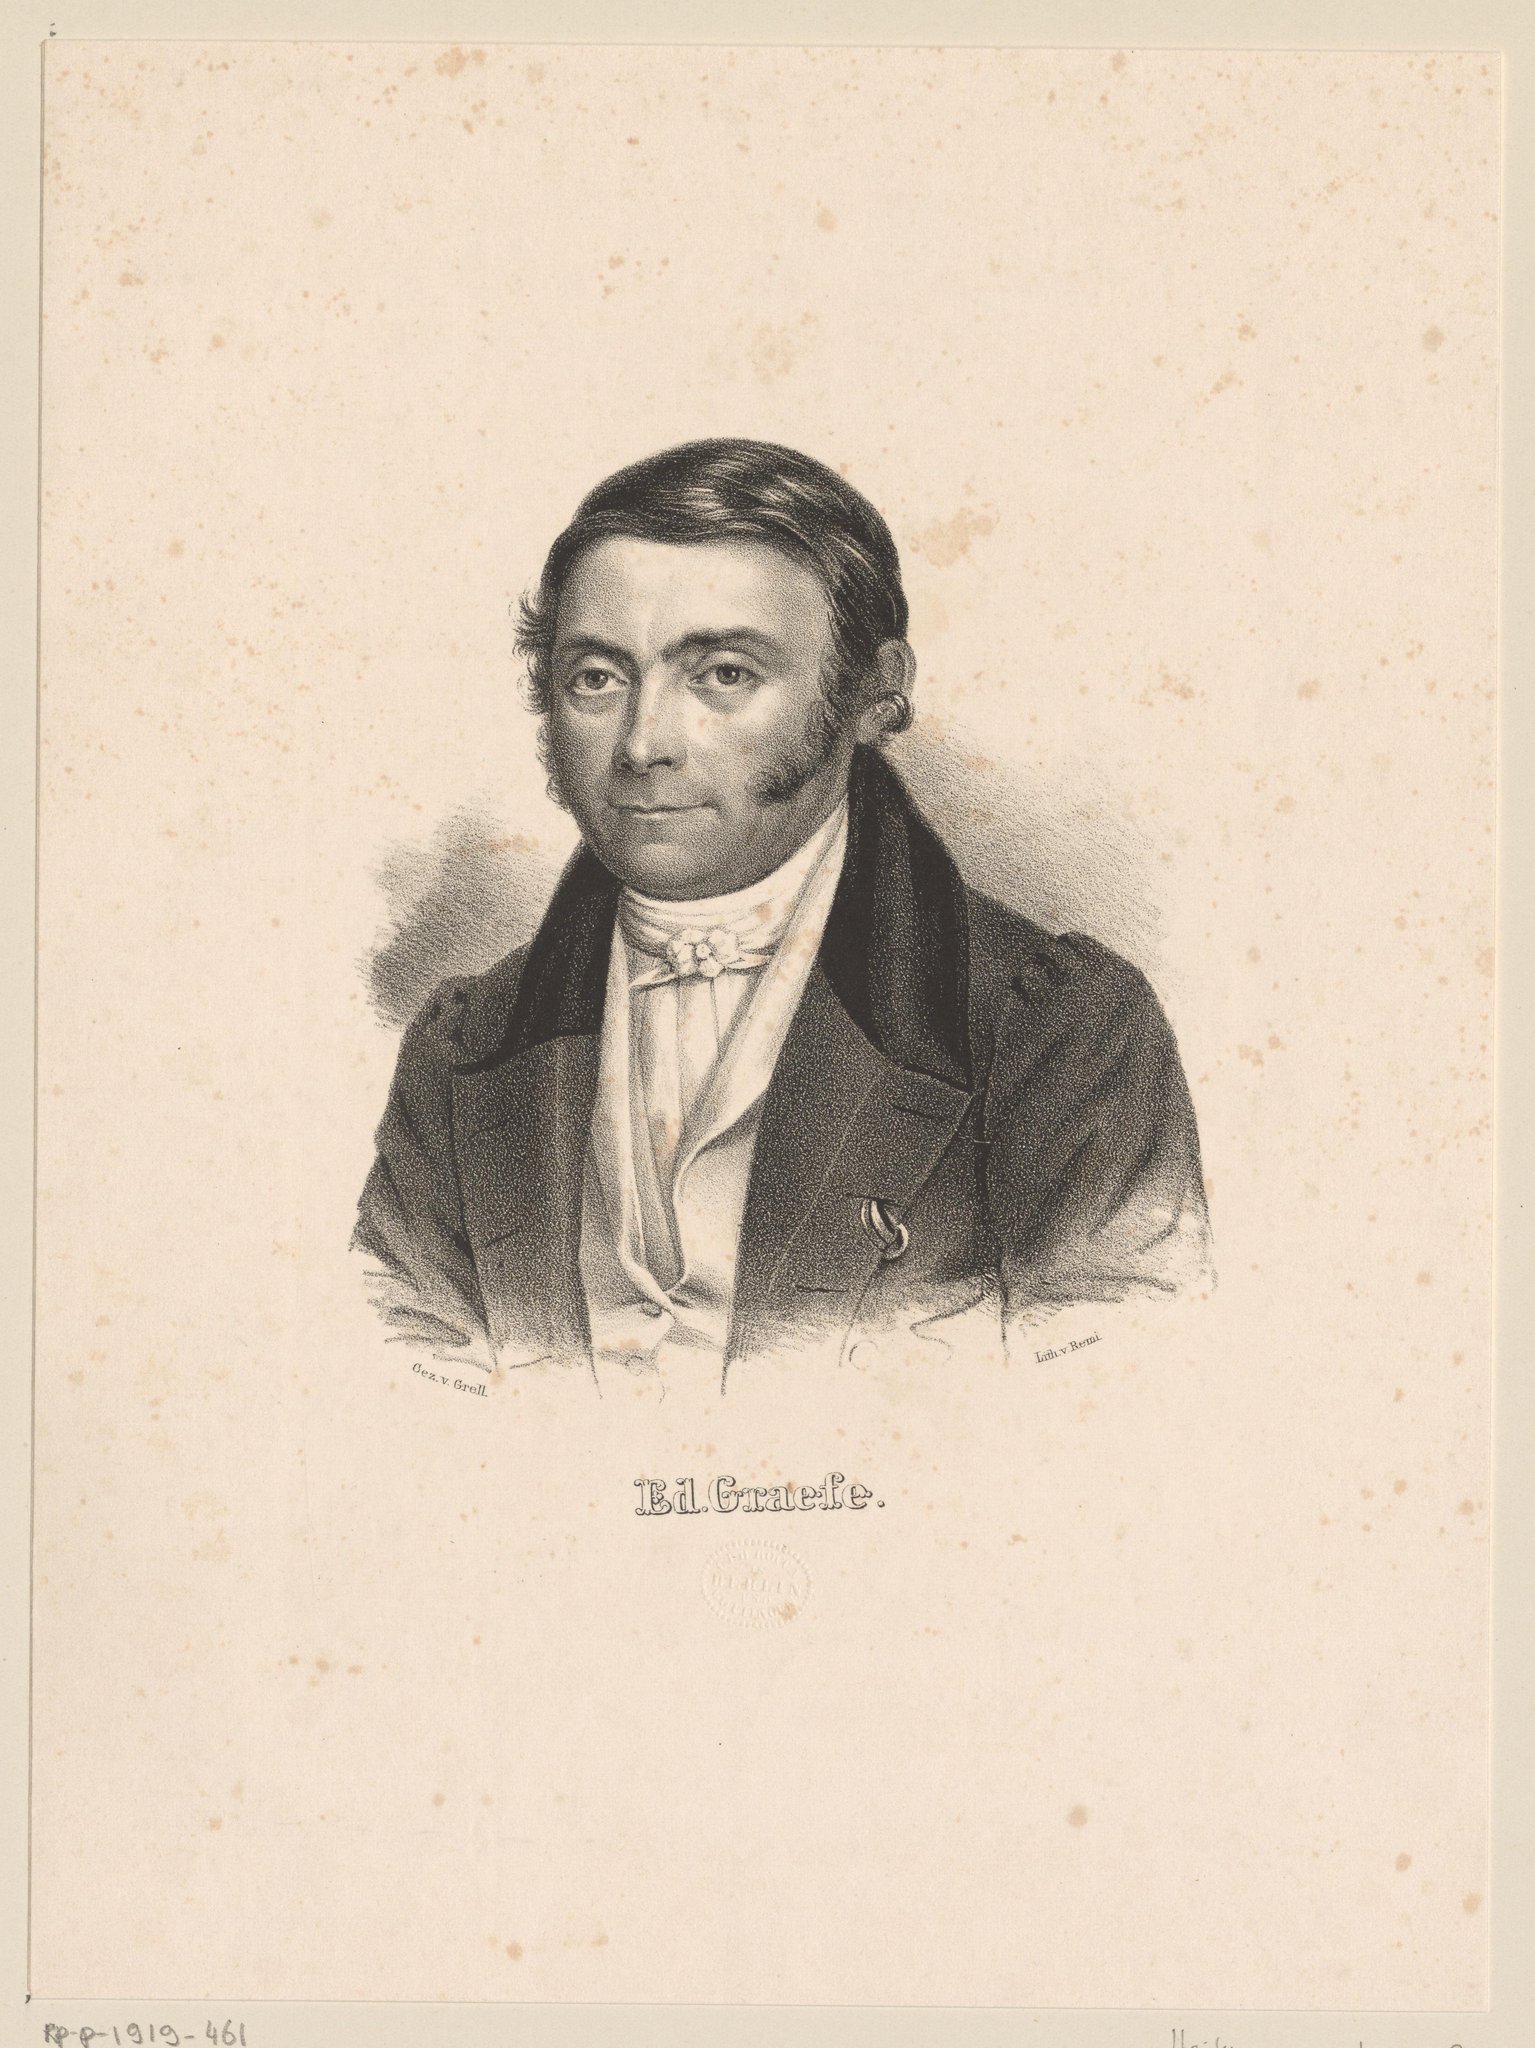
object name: print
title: Portret van Karl Ferdinand von Gräfe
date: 1830-1863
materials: paper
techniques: lithograph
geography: berlin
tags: karl ferdinand von gräfe, historical persons, physician, doctor (+ portrait of scholar, scientist), professor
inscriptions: check stamp: Lugt 5514, collector's mark: Lugt 2228